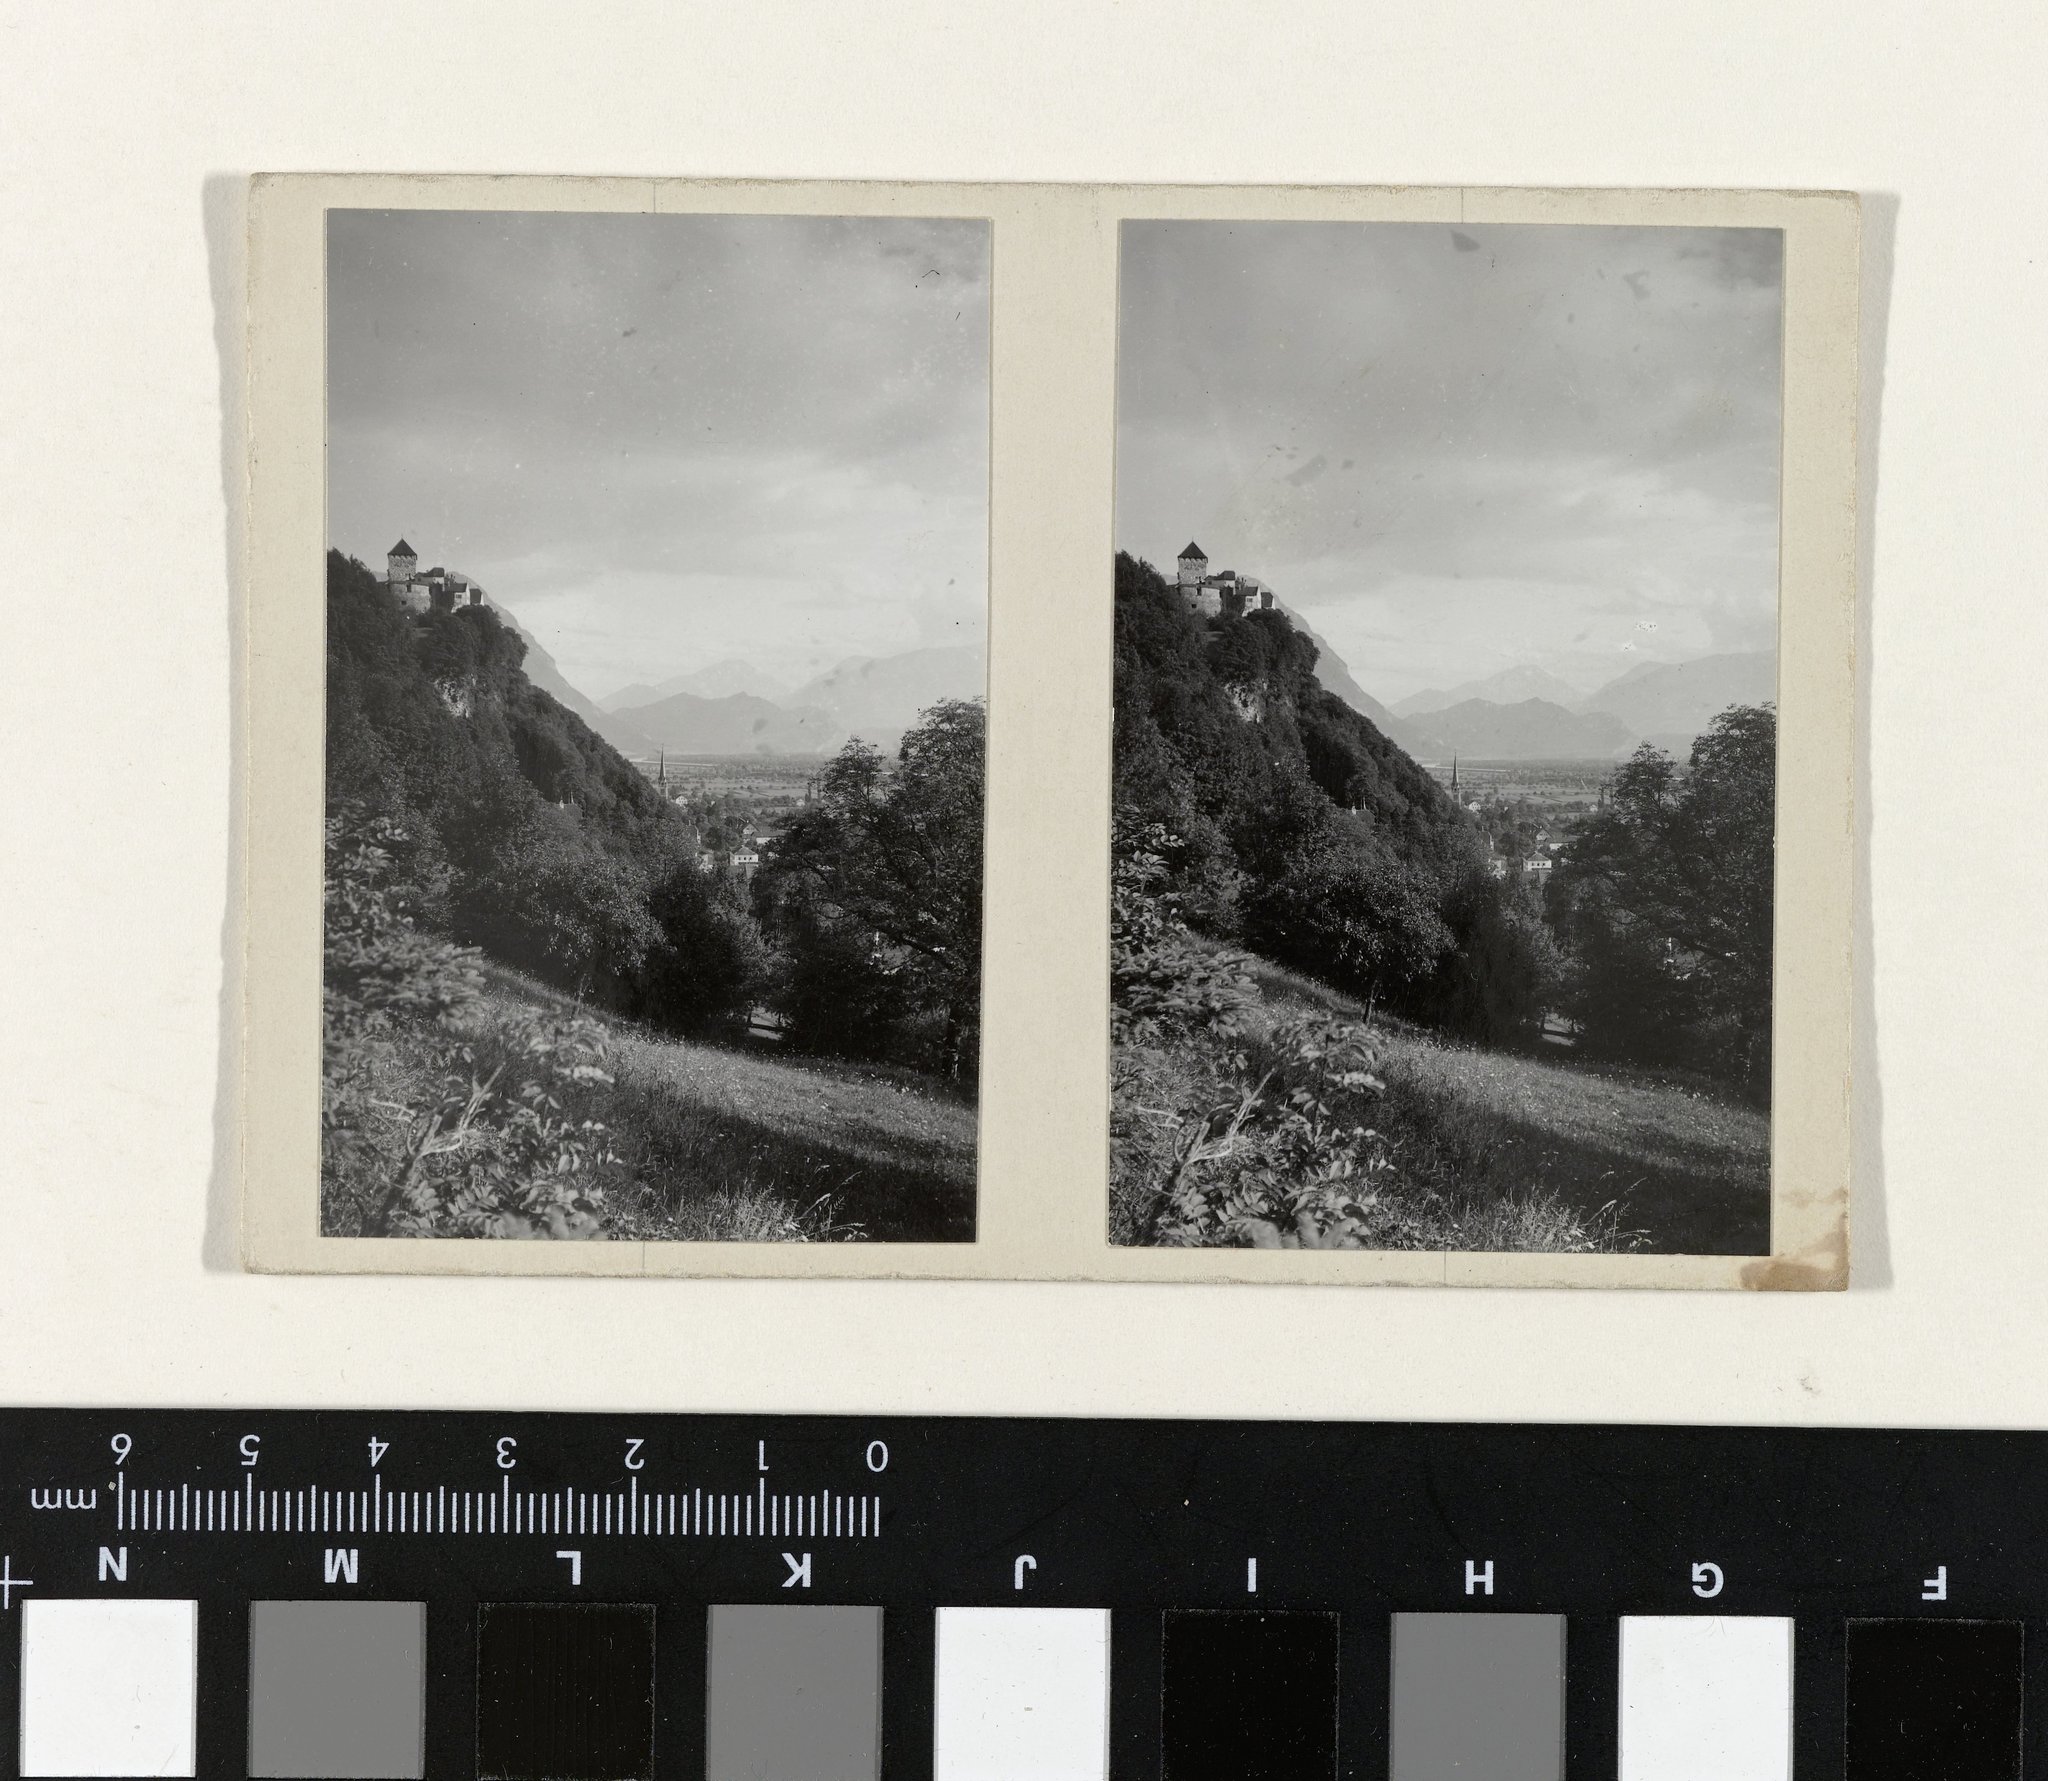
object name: stereograph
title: Dorpsgezicht over het Zwitserse Ragaz met op de heuvel een klein kasteel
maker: geldolph adriaan kessler (dolph)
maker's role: fotograaf, industrieel, voetballer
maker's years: 1884-1945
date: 1920-1945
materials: paper, photographic support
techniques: collodion silver print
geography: netherlands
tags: switzerland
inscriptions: title: ‘Le Ragaz’